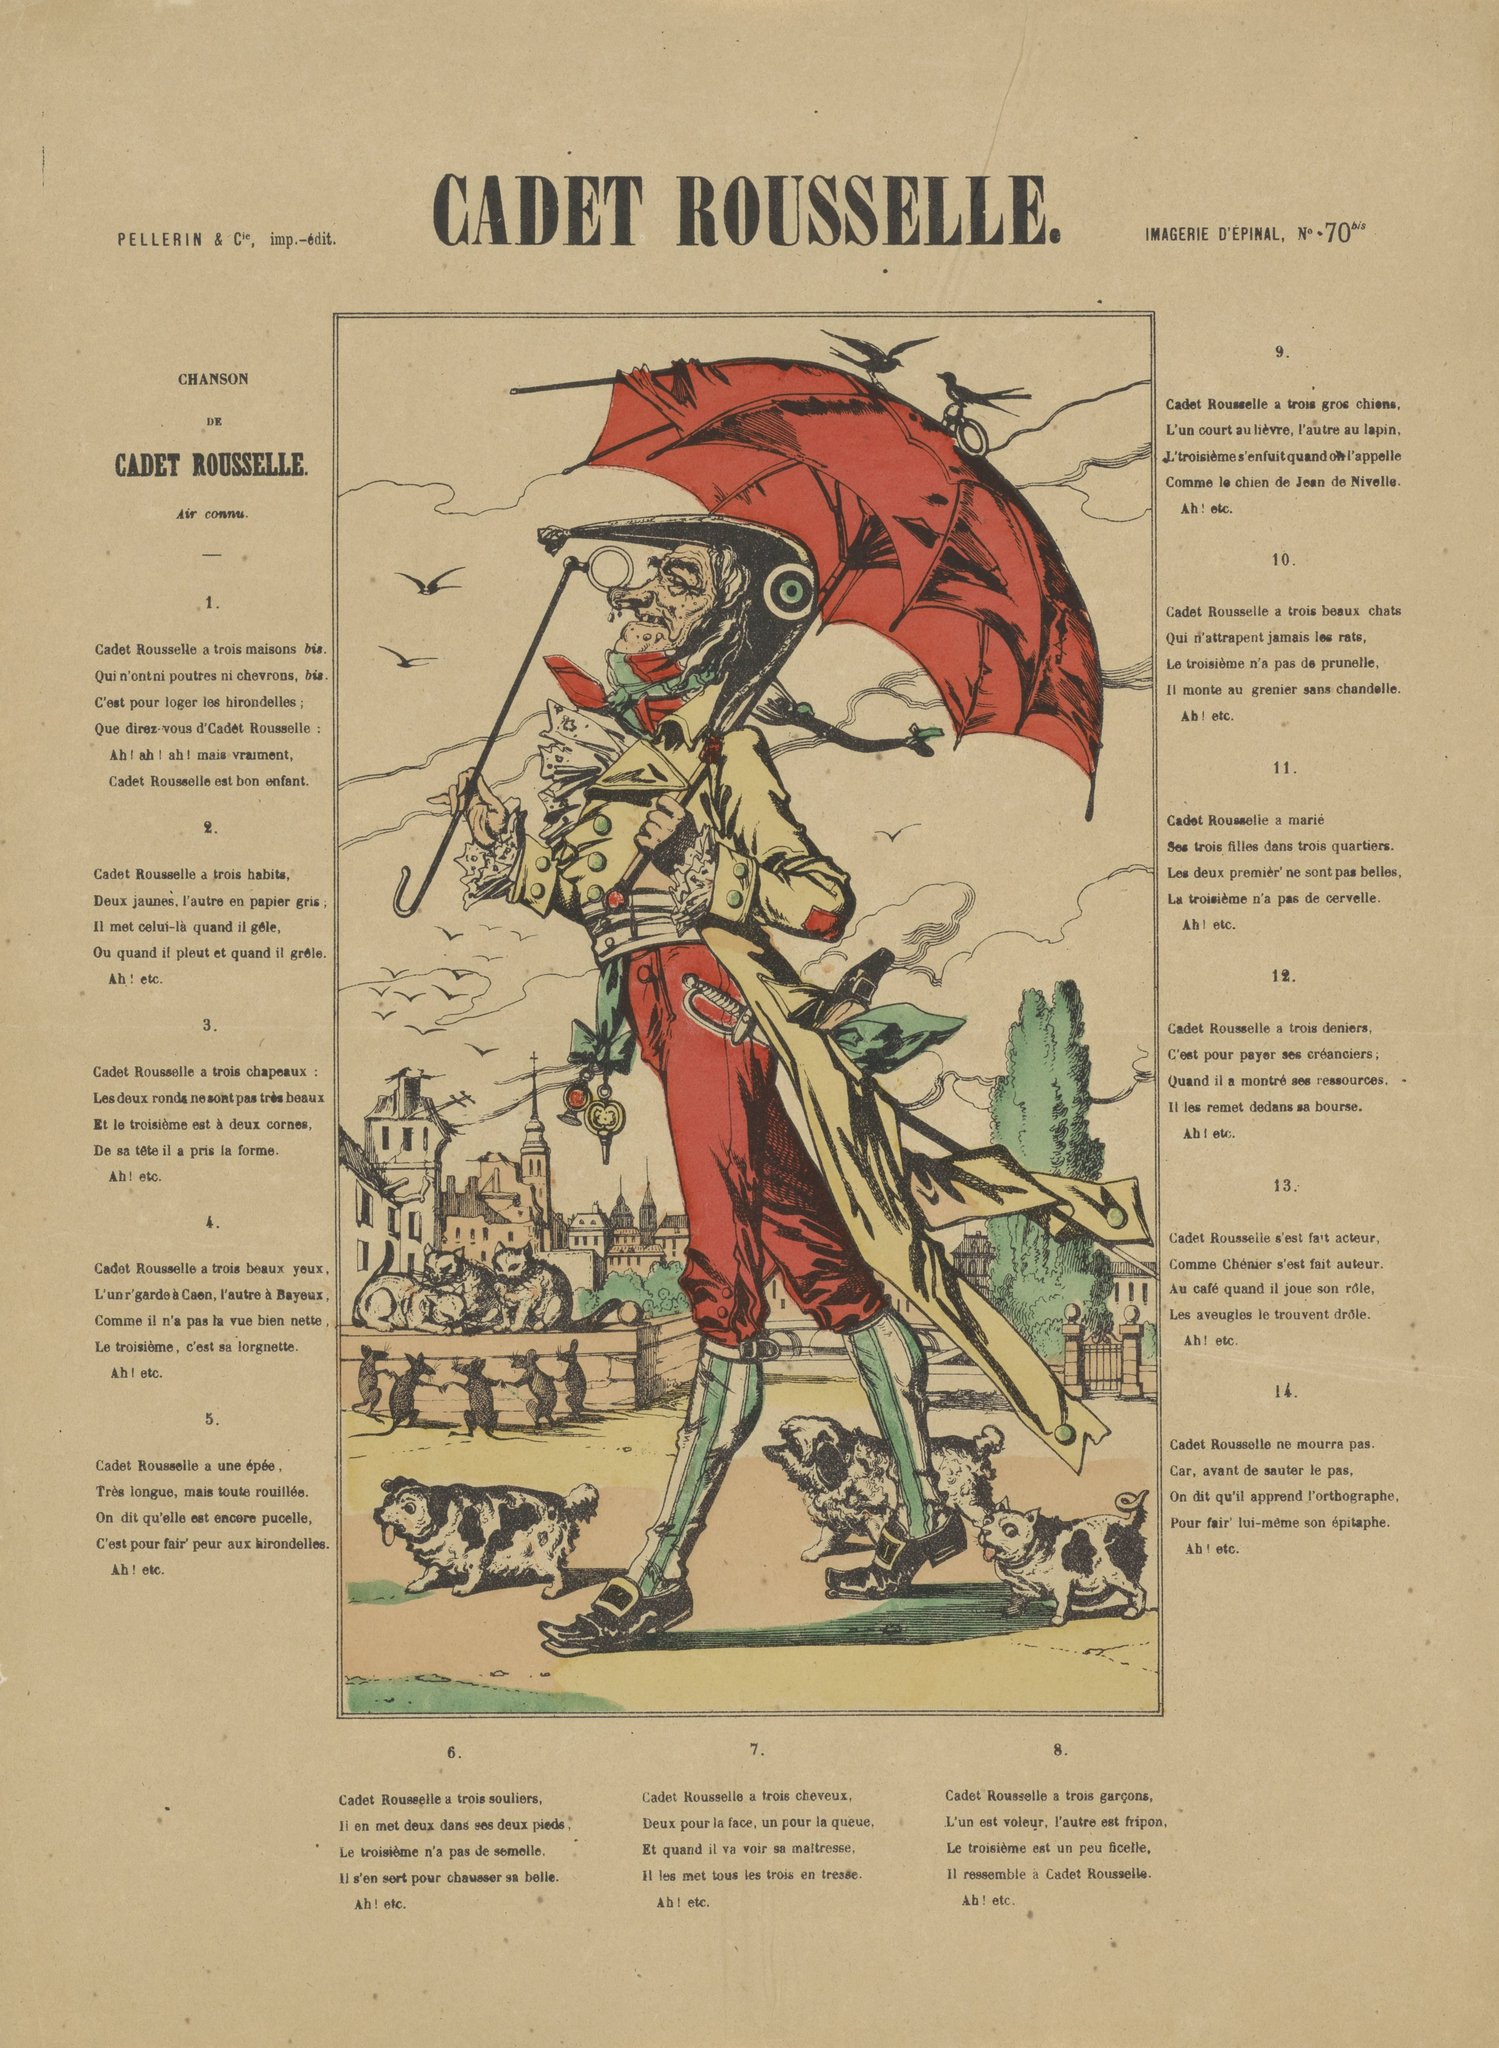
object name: popular print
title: Cadet Rousselle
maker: Anonymous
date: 1791-1900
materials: paper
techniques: colour, letterpress printing, lithograph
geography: epinal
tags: walking the dog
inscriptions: collector's mark: Lugt 2760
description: Cadet Rouselle. Een lelijke man, in militair uniform met kapotte schoenen en paraplu, wandelt met drie hondjes. Op de achtergrond drie katten, vijf dansende muizen en een stadje. Rondom de afbeelding tekst in het Frans. Genummerd rechtsboven: No. 70bis.